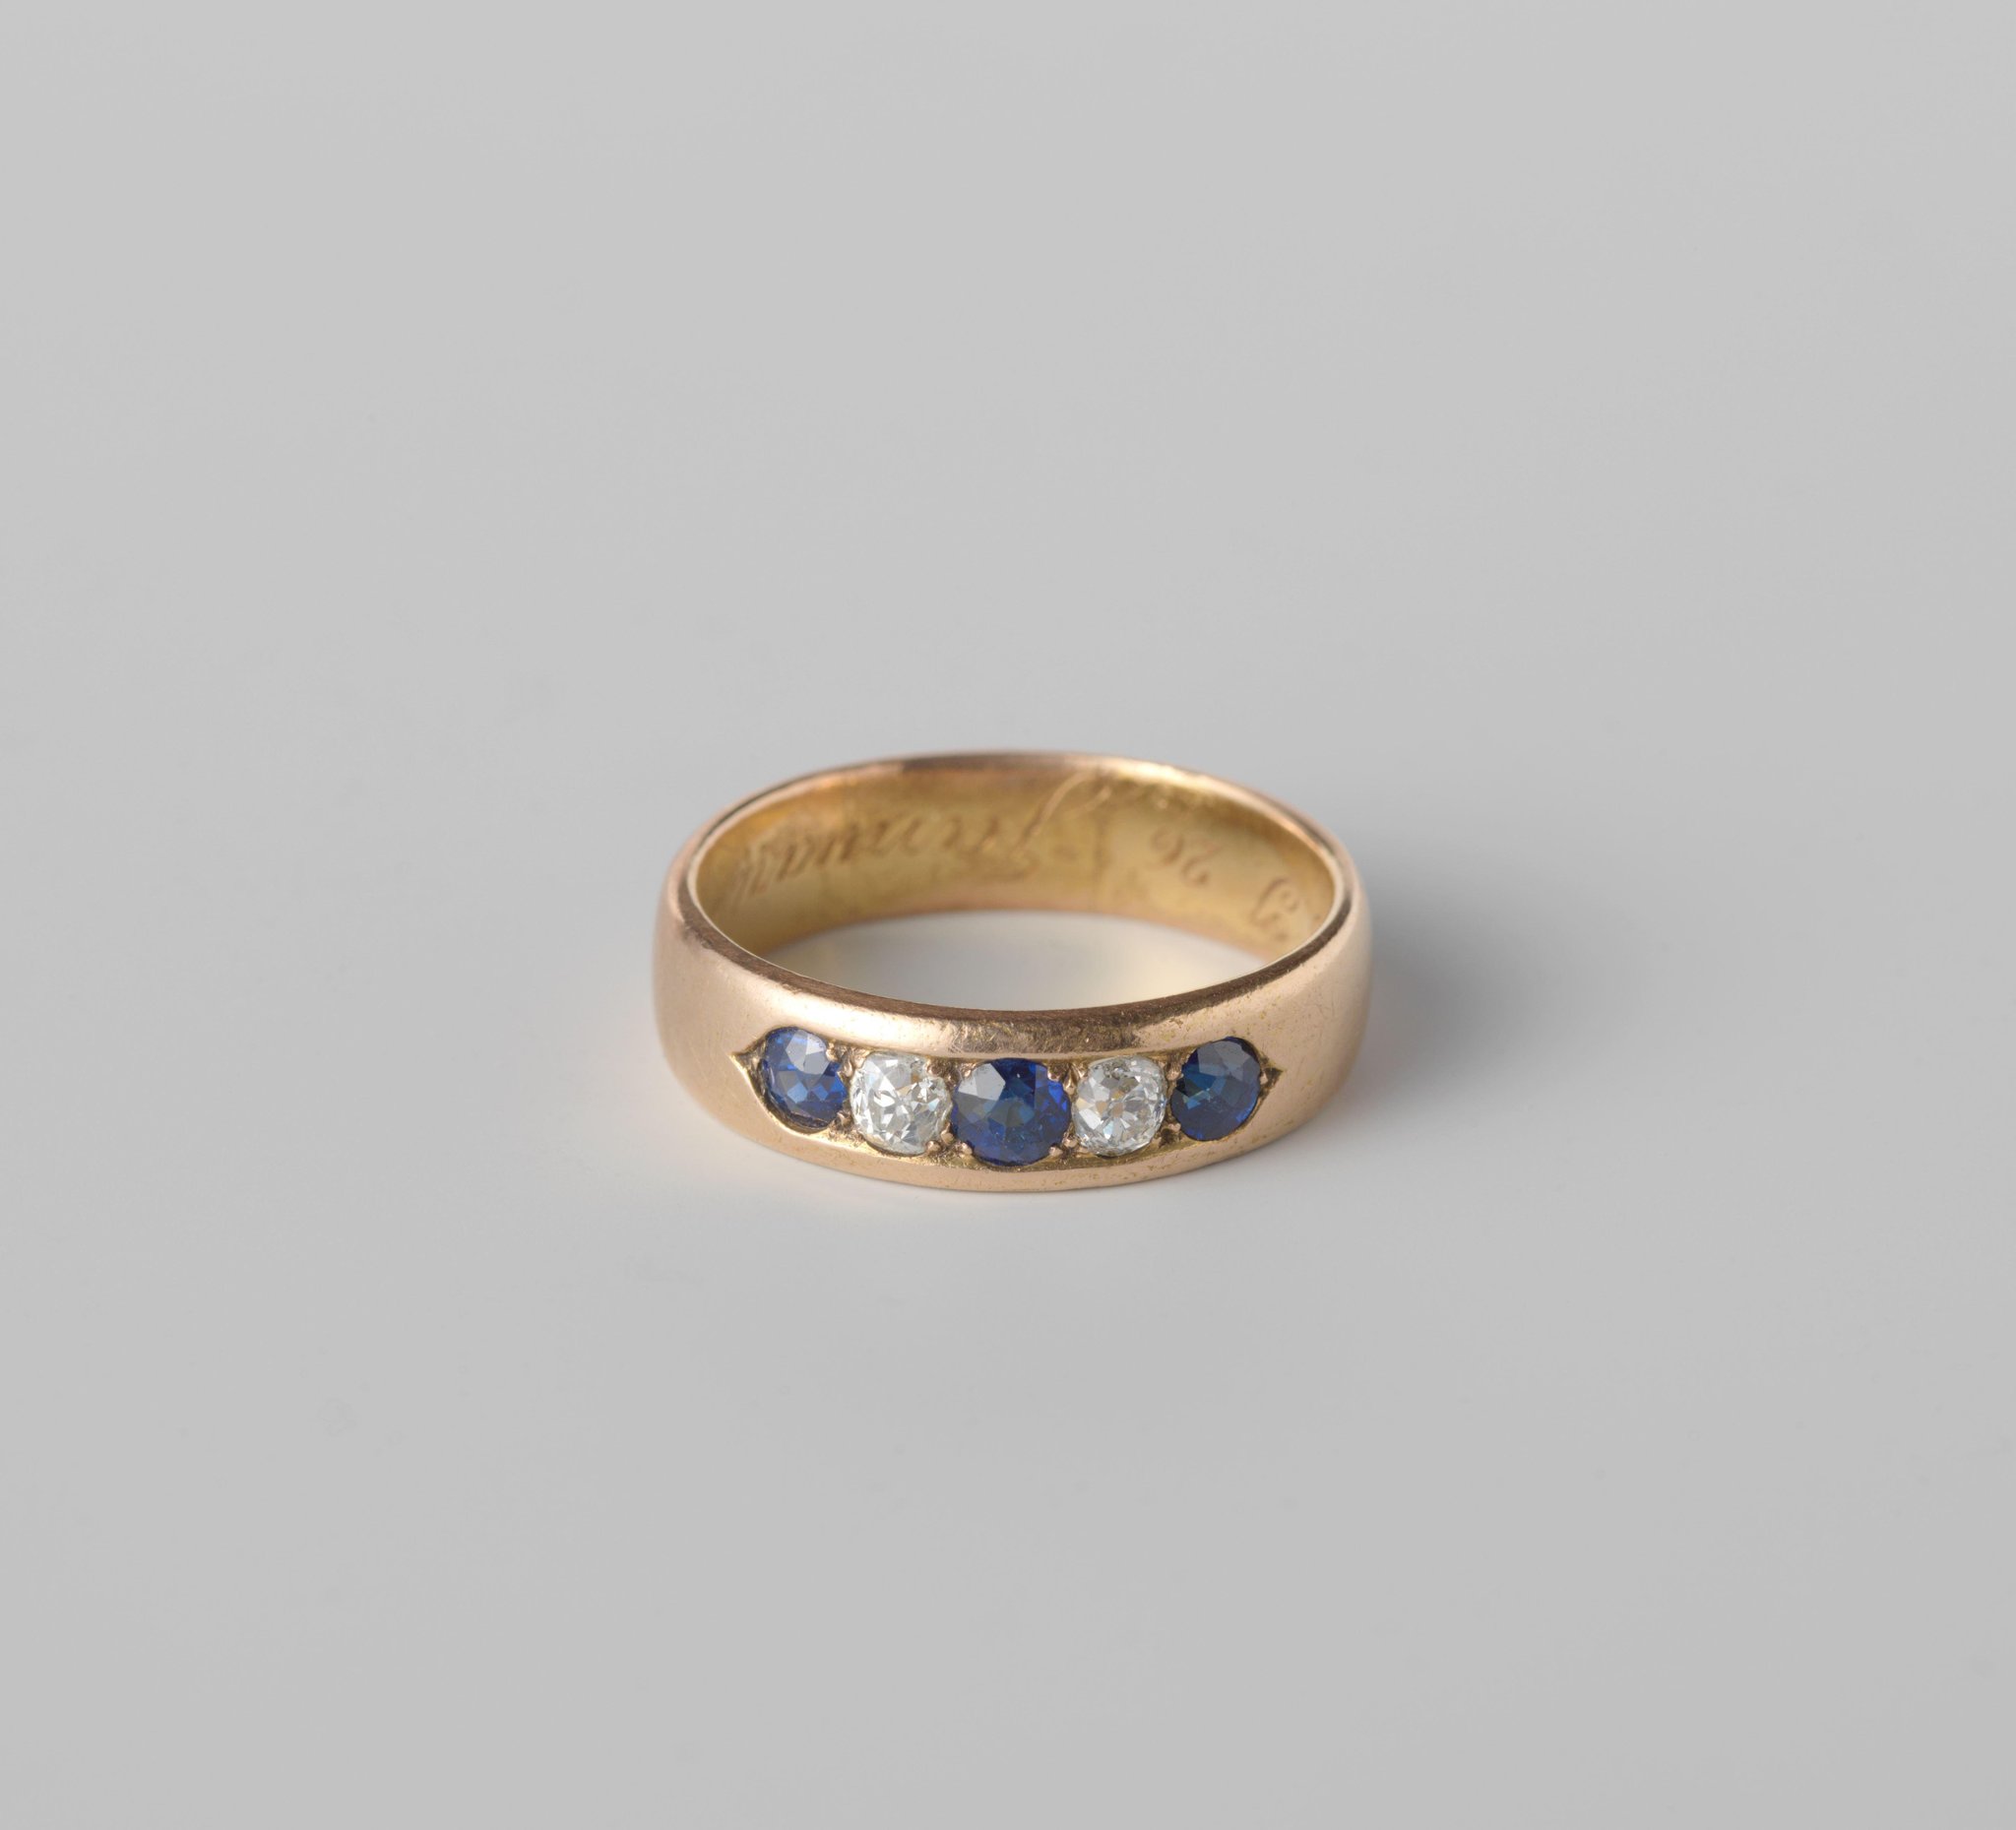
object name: ring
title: Ring van goud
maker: Anonymous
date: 1911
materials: diamond, gold, gemstone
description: Ring van goud. Bestaande uit een gladde band, bovenop bezet met 3 saffieren en 2 briljanten. Inscriptie: E.A.J. 26 Januari 1911.